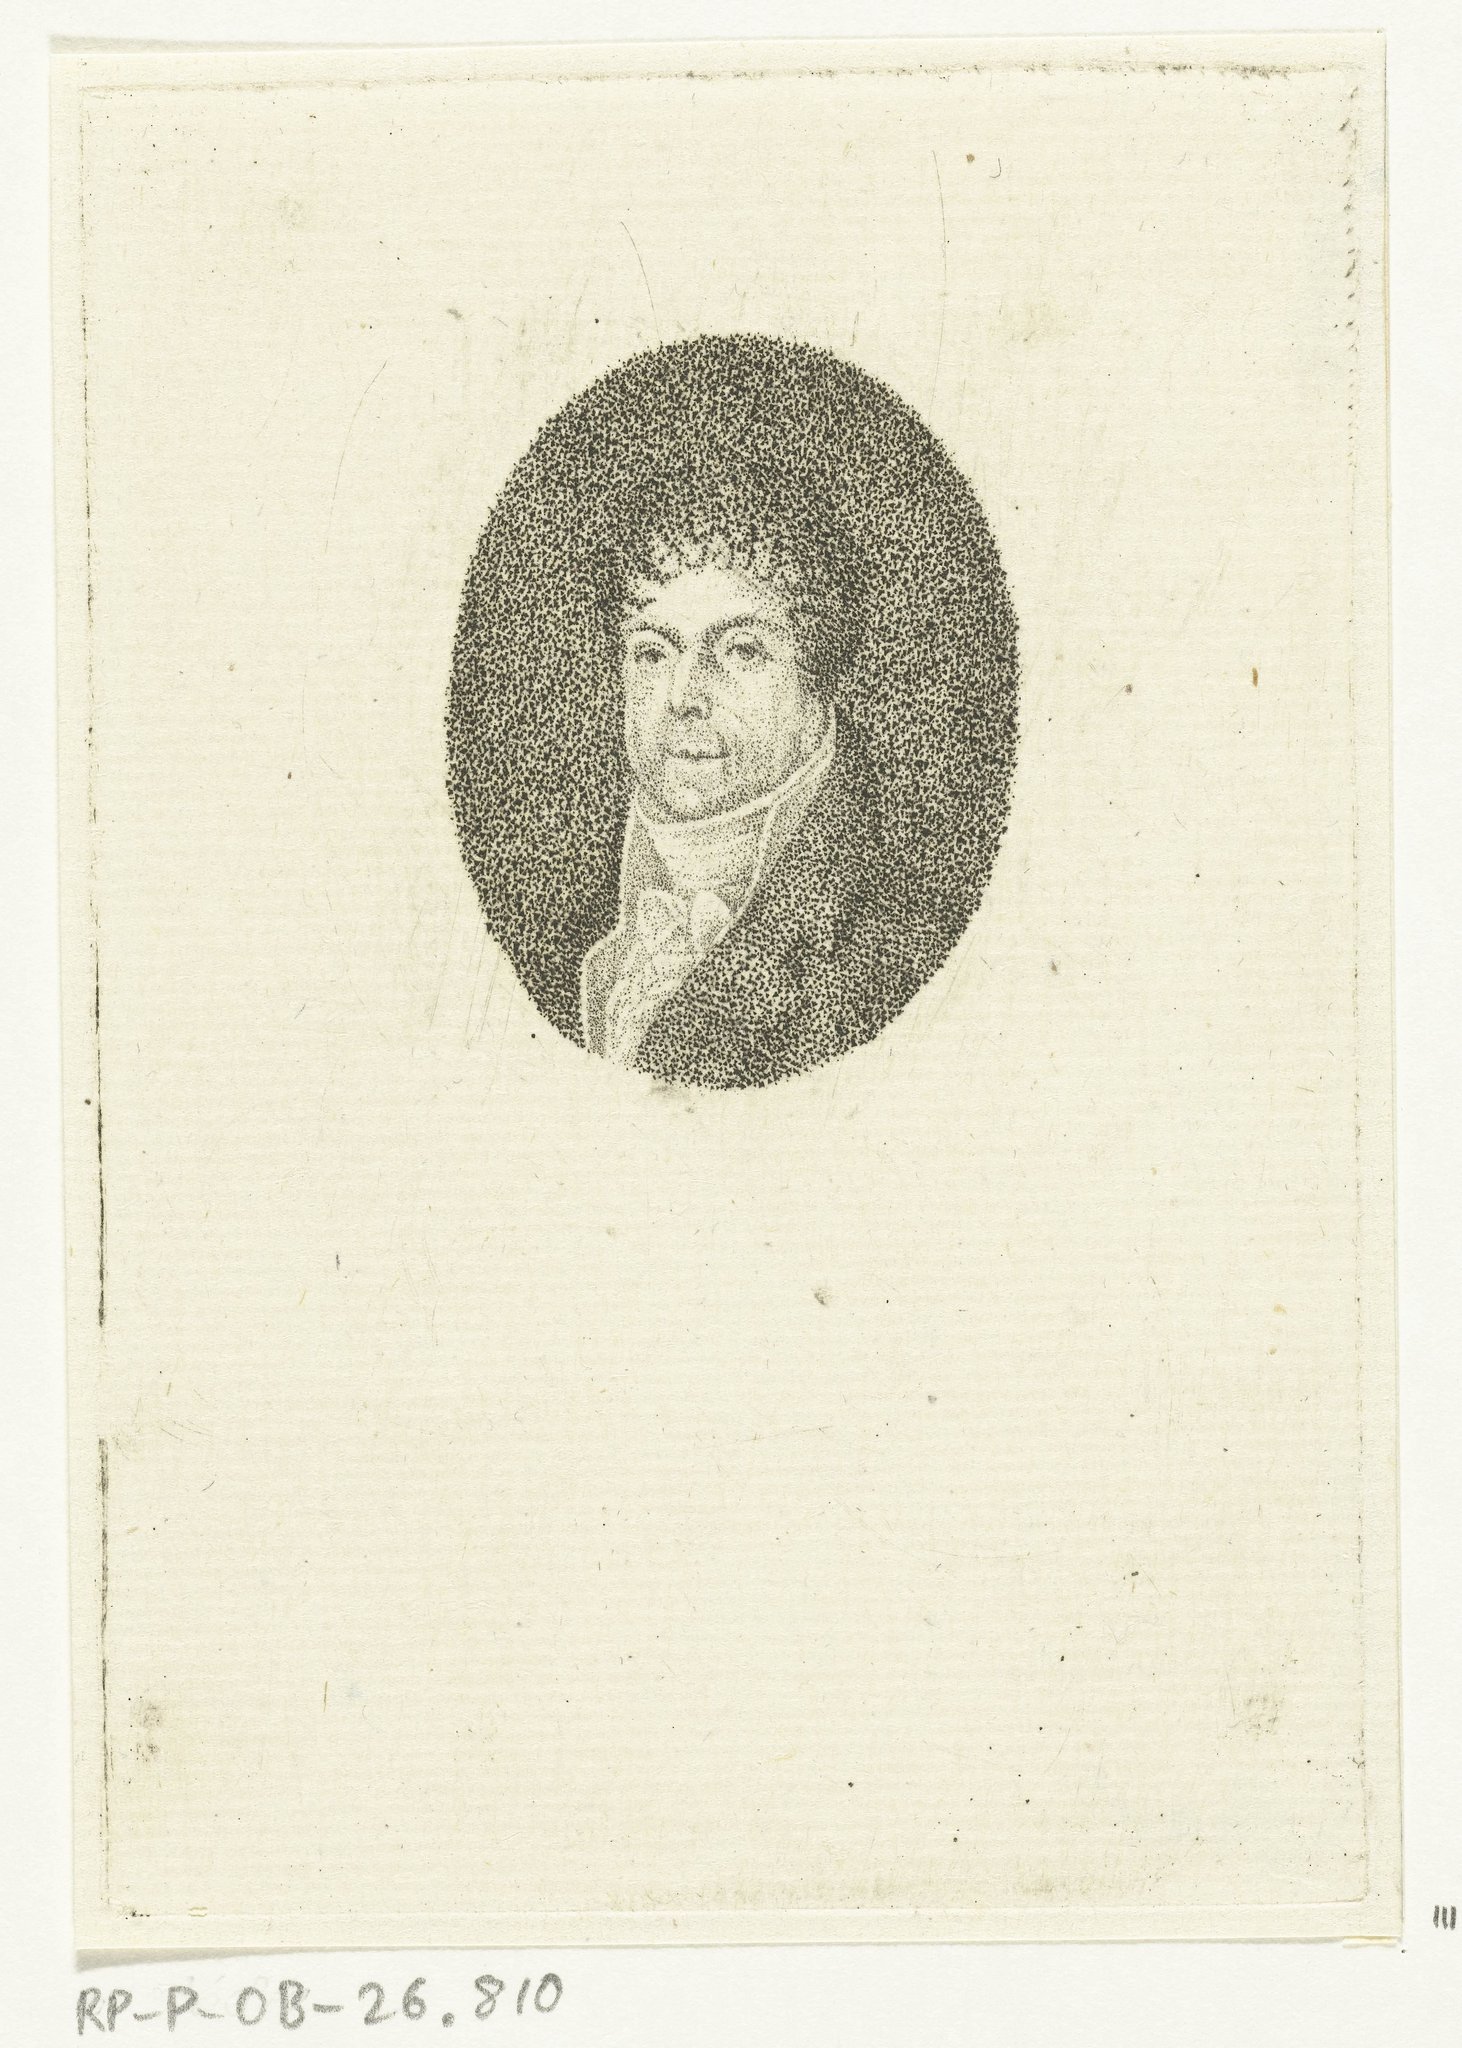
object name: print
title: Portret van J. Gazel, in ovaal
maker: anthonie van den bos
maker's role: draughtsman, print maker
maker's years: 1763-1838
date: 1800-1838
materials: paper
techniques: stippled etching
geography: netherlands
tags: anonymous historical person portrayed alone (+ three-quarter view portrait)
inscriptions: collector's mark: Lugt 2228